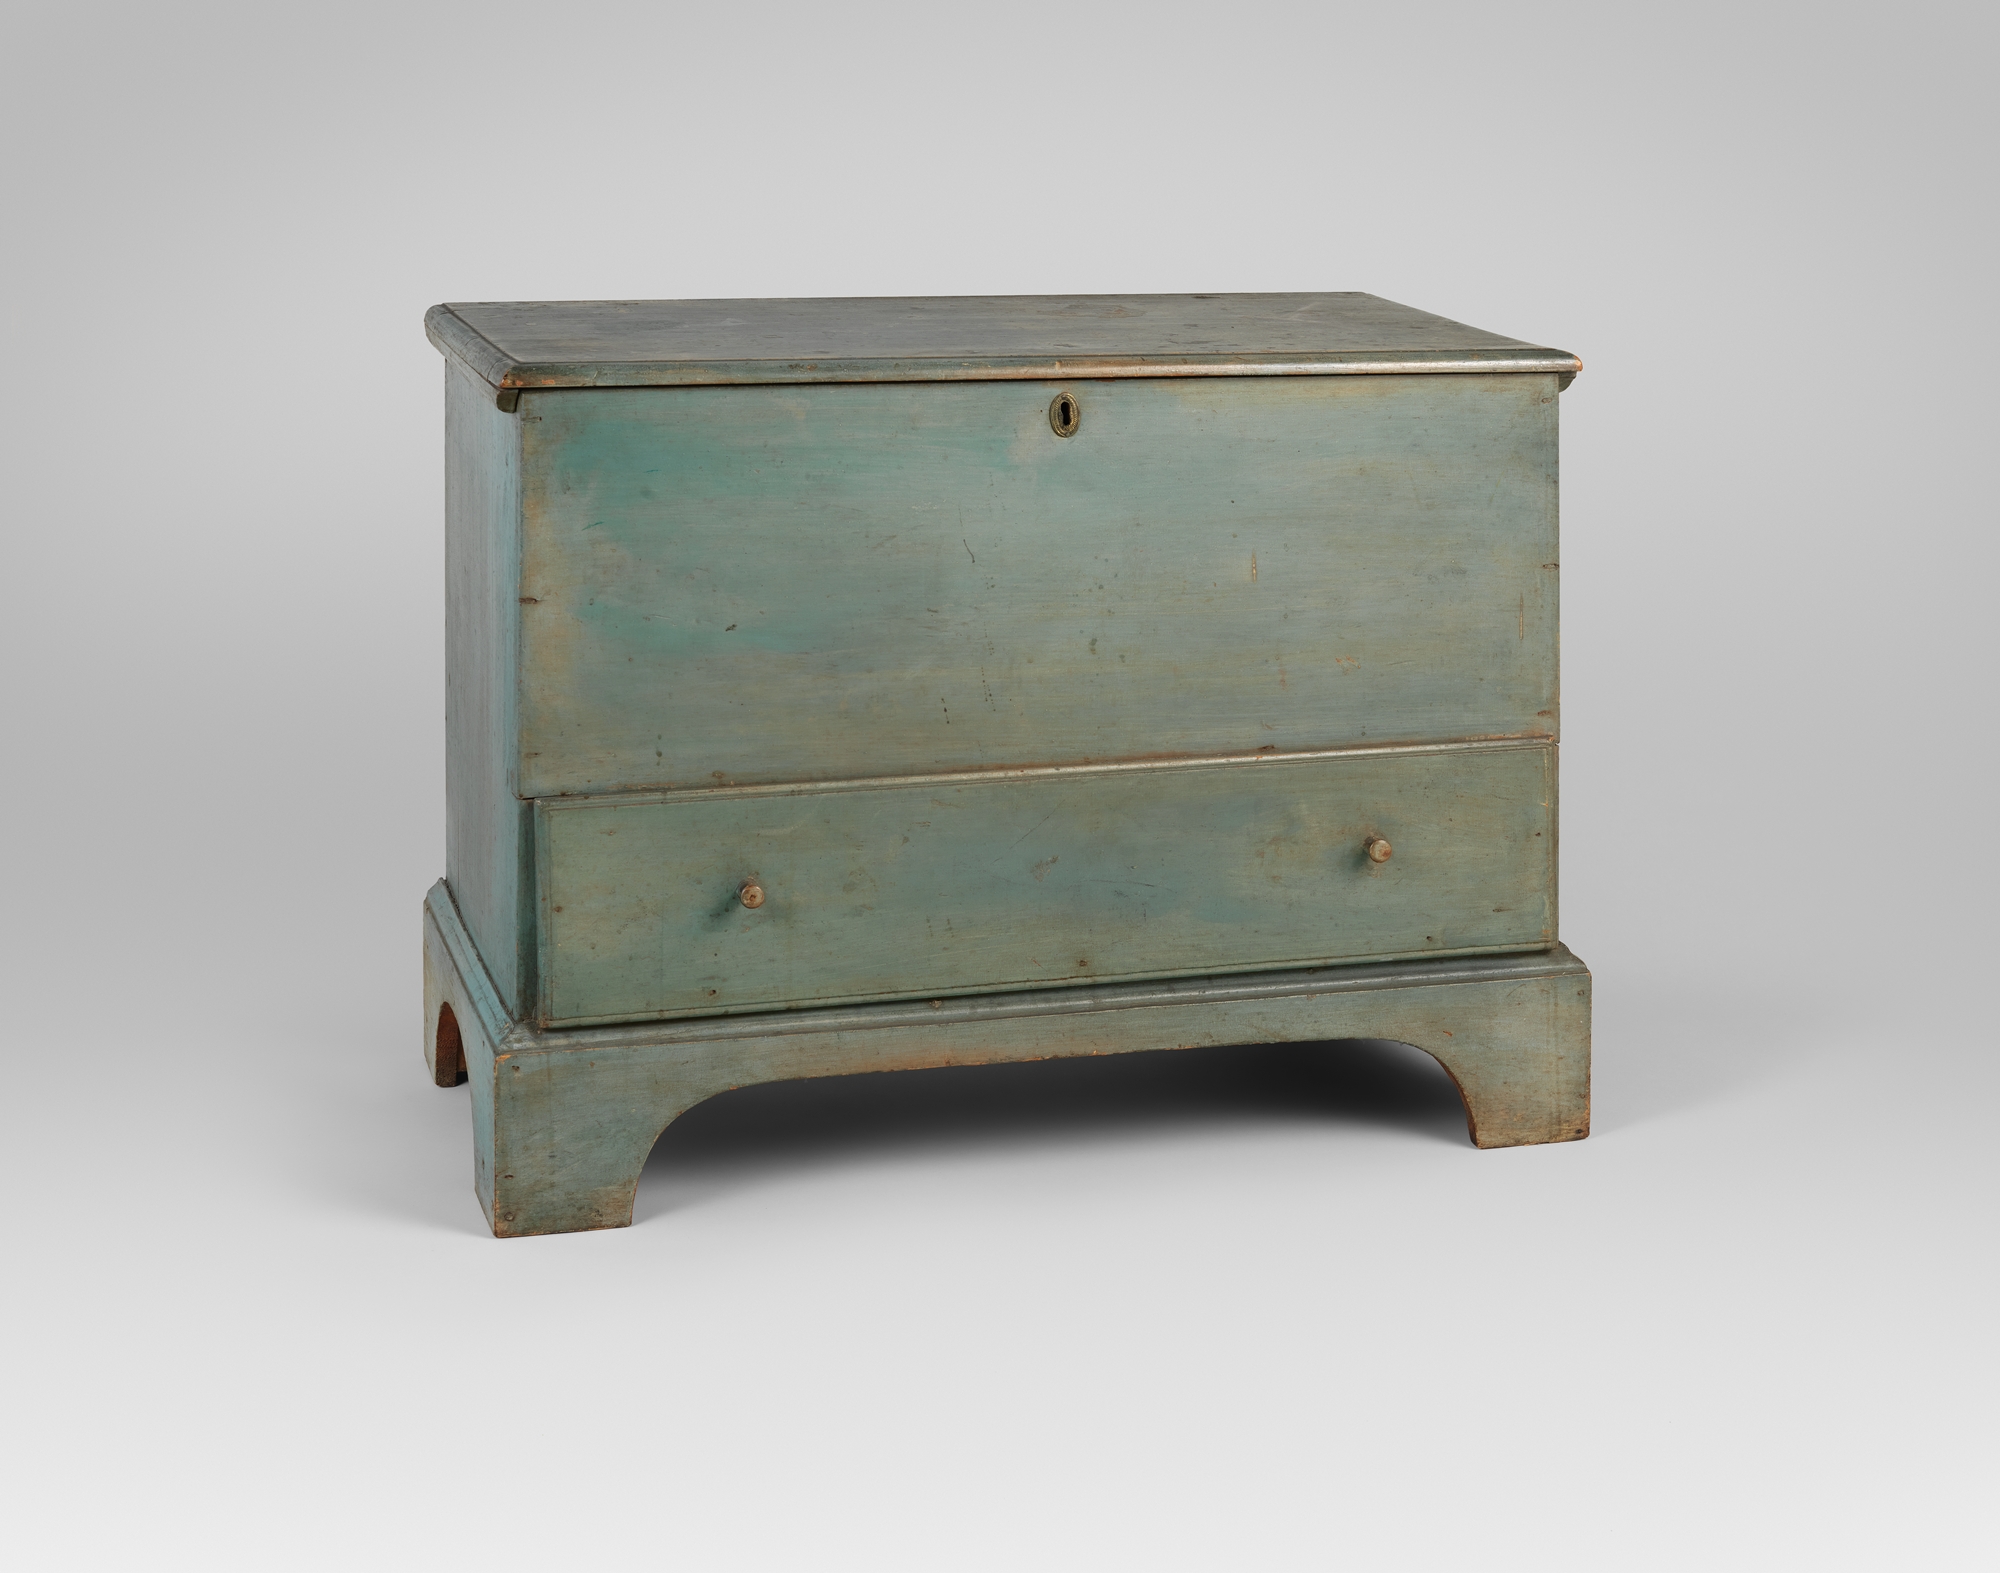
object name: blanket chest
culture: american, shaker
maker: united society of believers in christ’s second appearing (“shakers”)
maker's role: maker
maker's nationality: american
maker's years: 1750-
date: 1835-1875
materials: wood